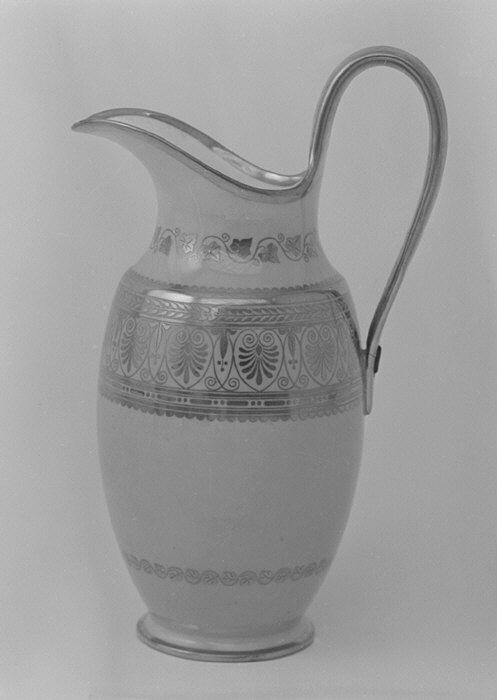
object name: milk jug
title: Milk jug (pot à lait pestum) (part of a service)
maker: sèvres manufactory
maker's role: manufactory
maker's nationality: french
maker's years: 1740-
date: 1844-1846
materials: hard paste porcelain